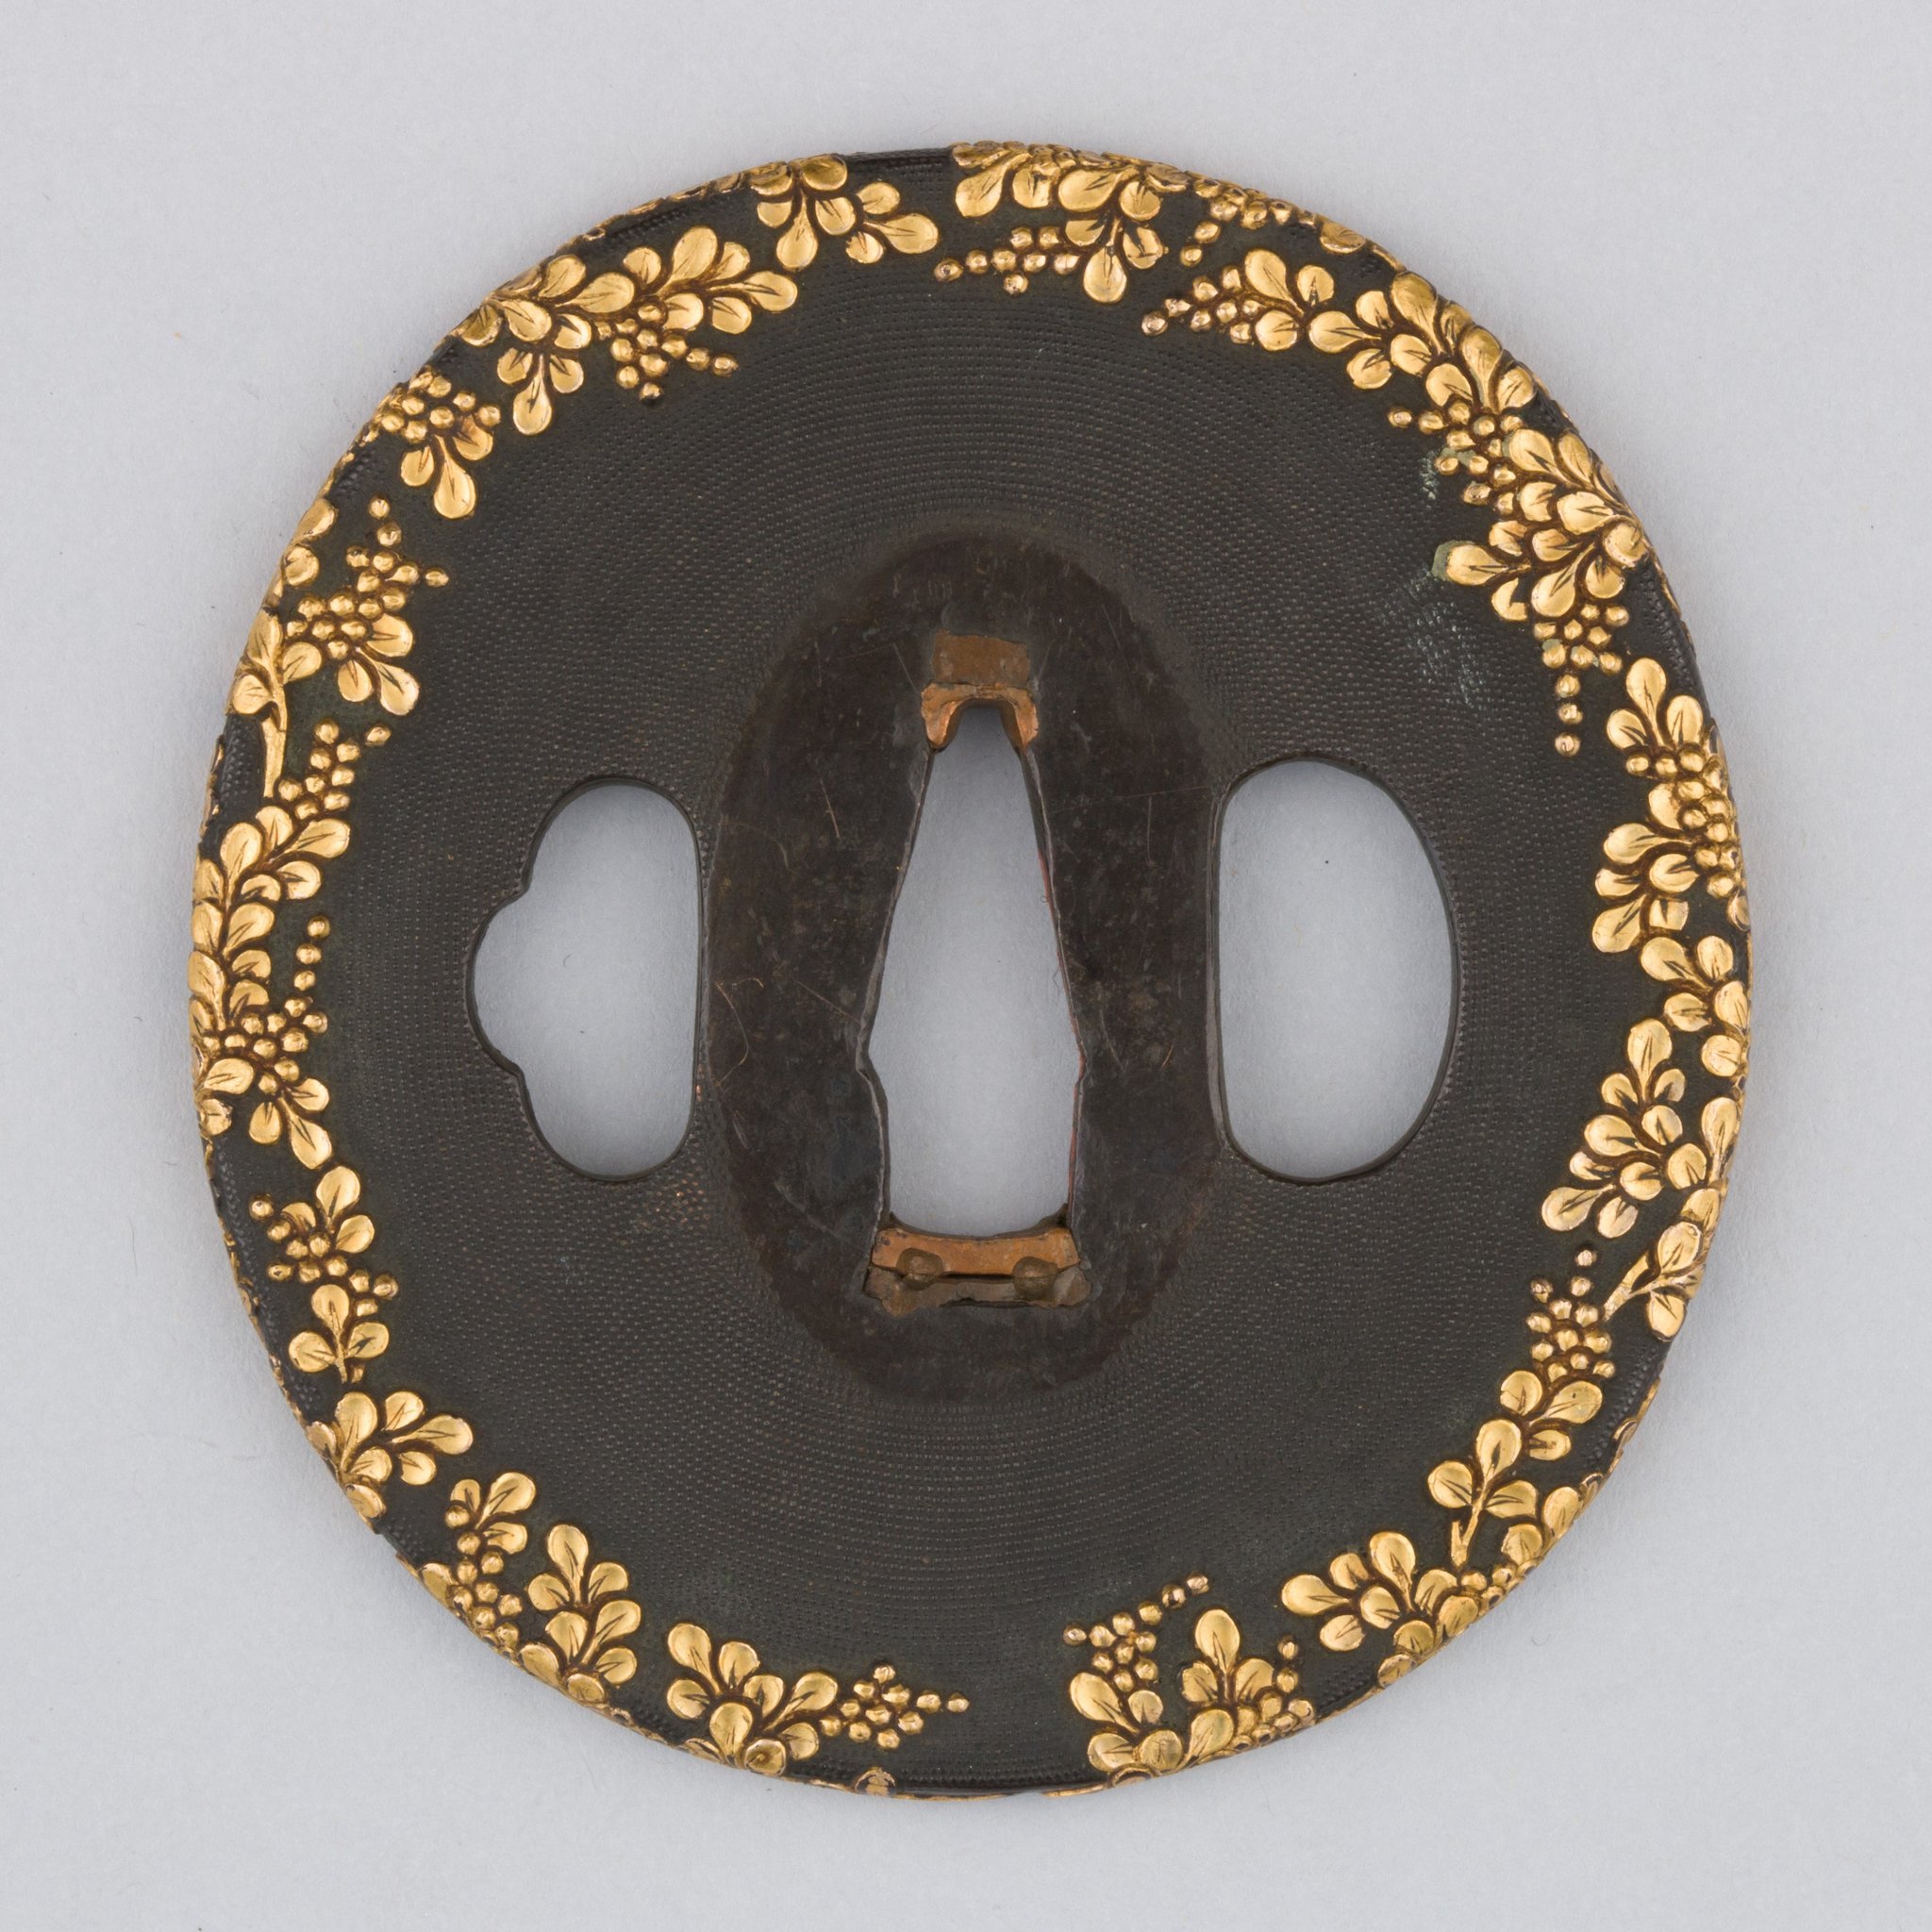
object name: sword guard tsuba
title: Sword Guard (Tsuba)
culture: japanese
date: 1615-1868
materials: copper, gold alloy, gold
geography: japan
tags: leaves